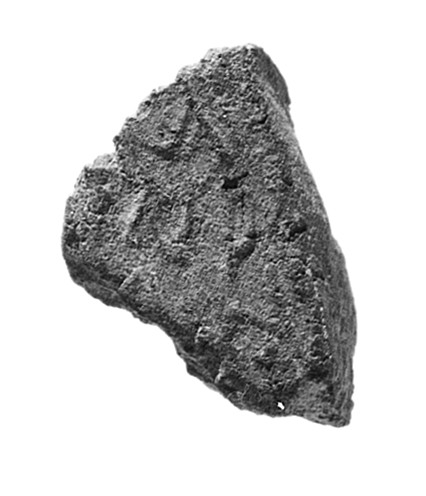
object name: sealing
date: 1981-1640 BCE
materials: mud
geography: egypt